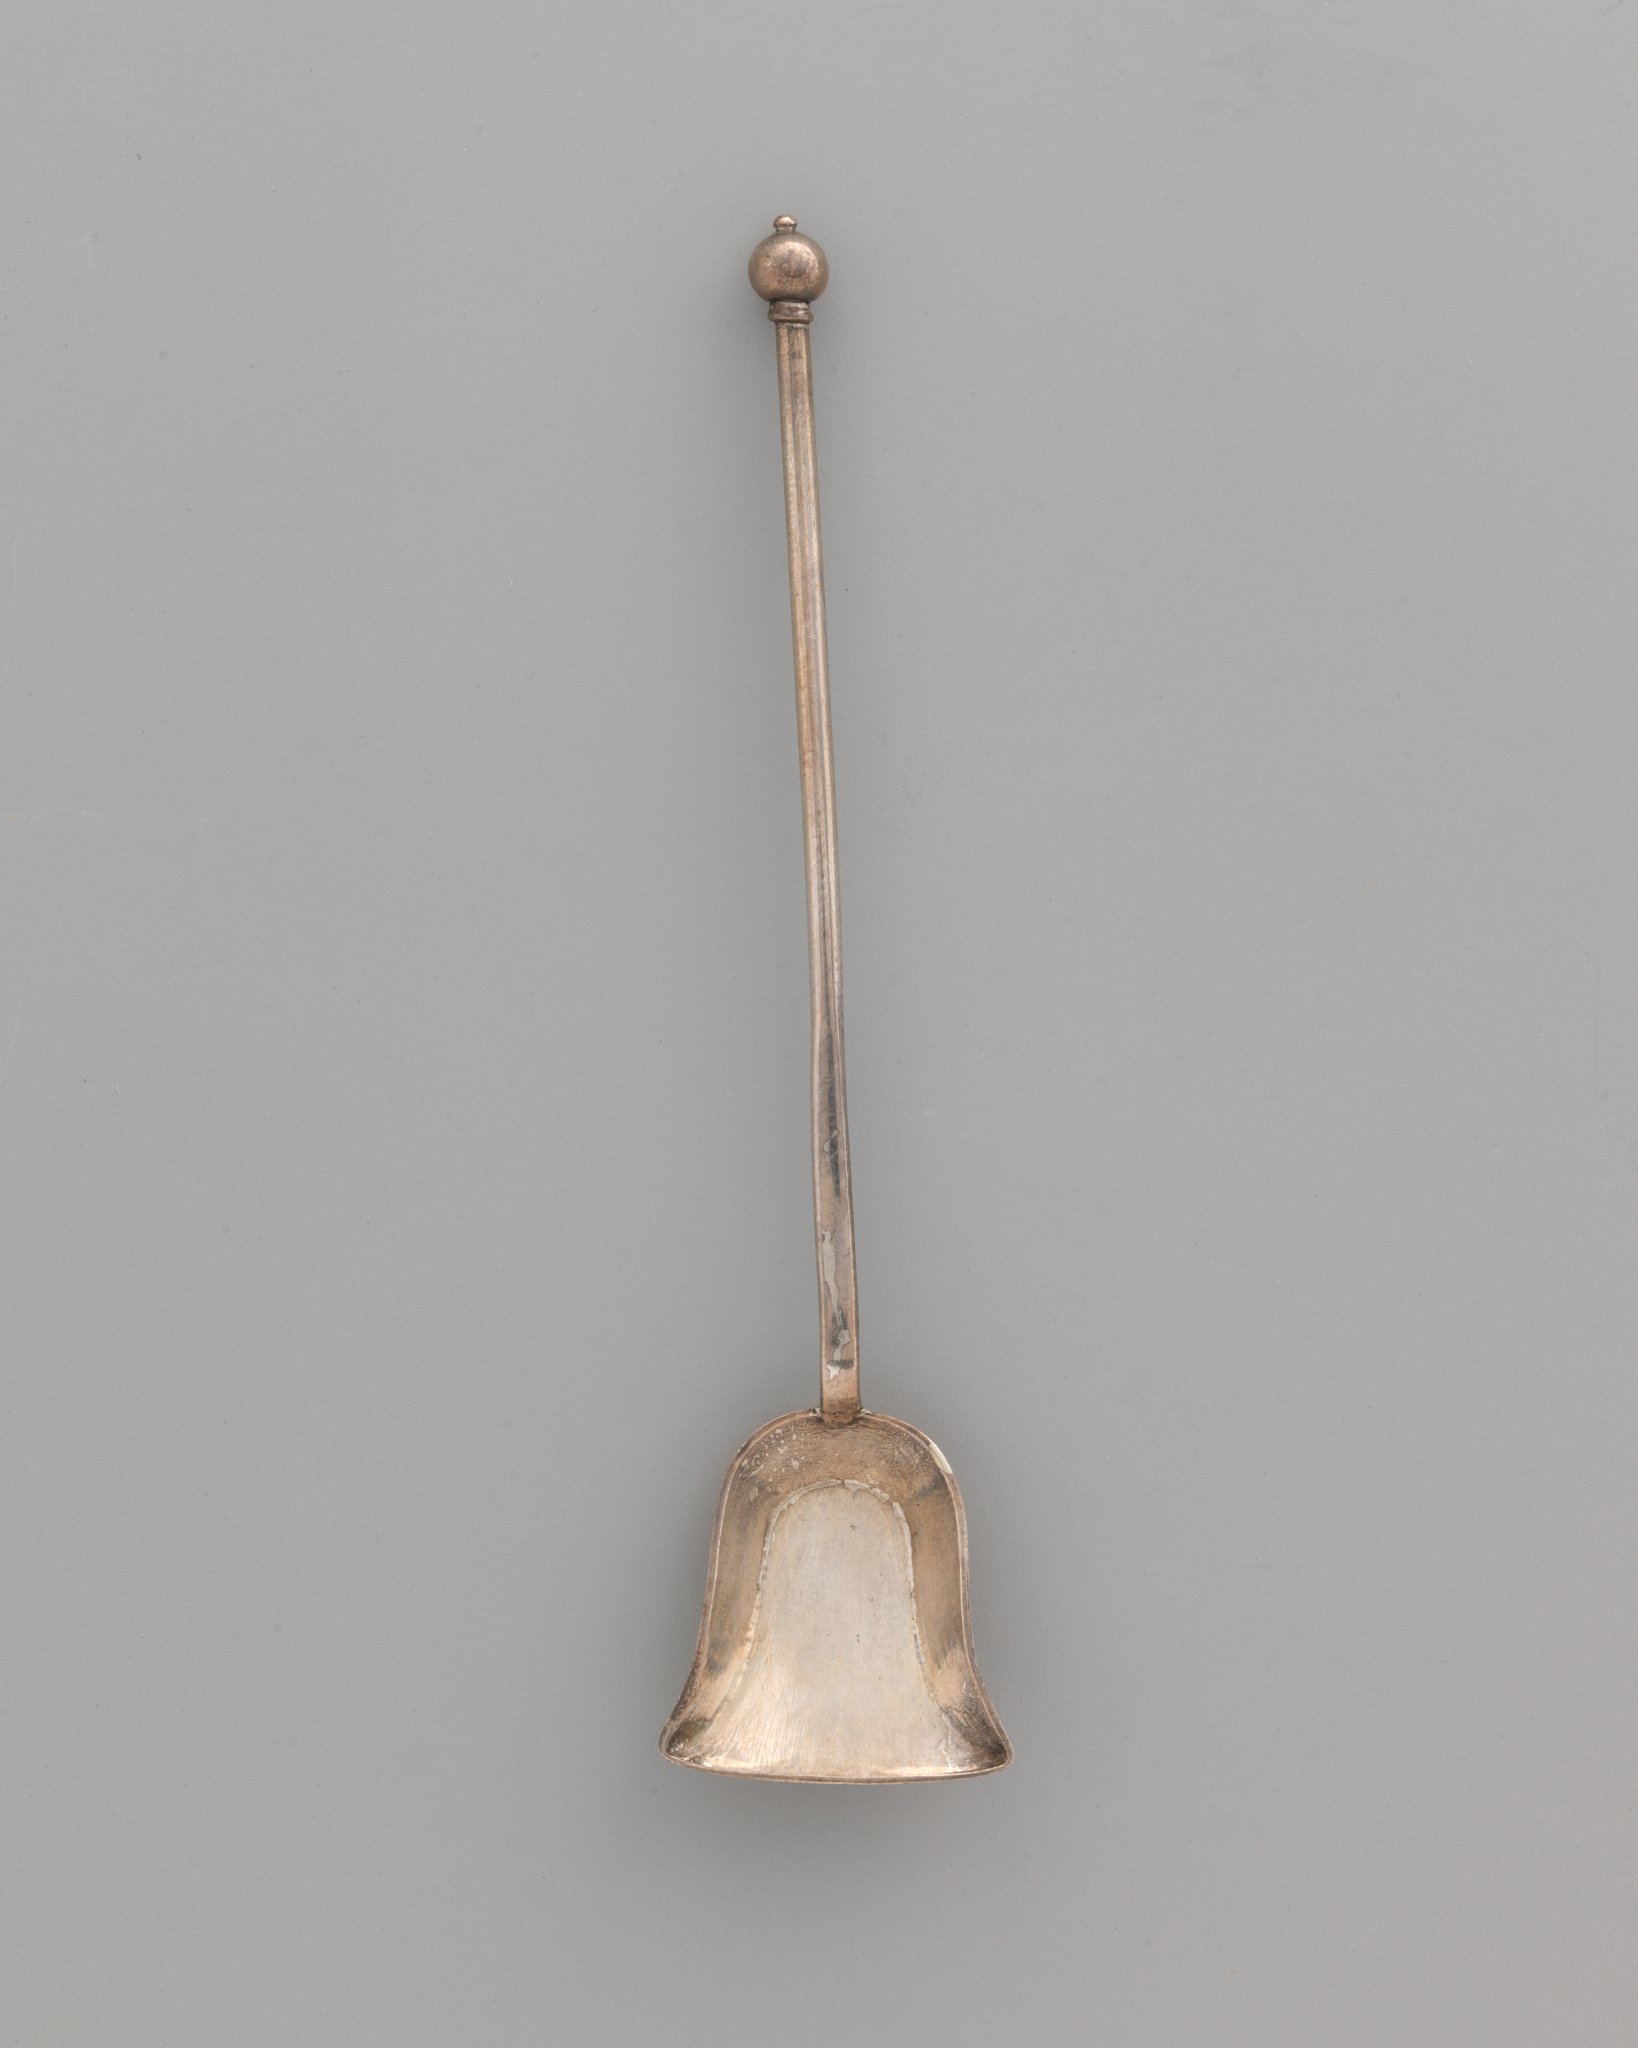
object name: shovel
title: Miniature shovel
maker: david clayton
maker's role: maker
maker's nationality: british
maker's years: 1659-1719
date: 1720-1730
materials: silver